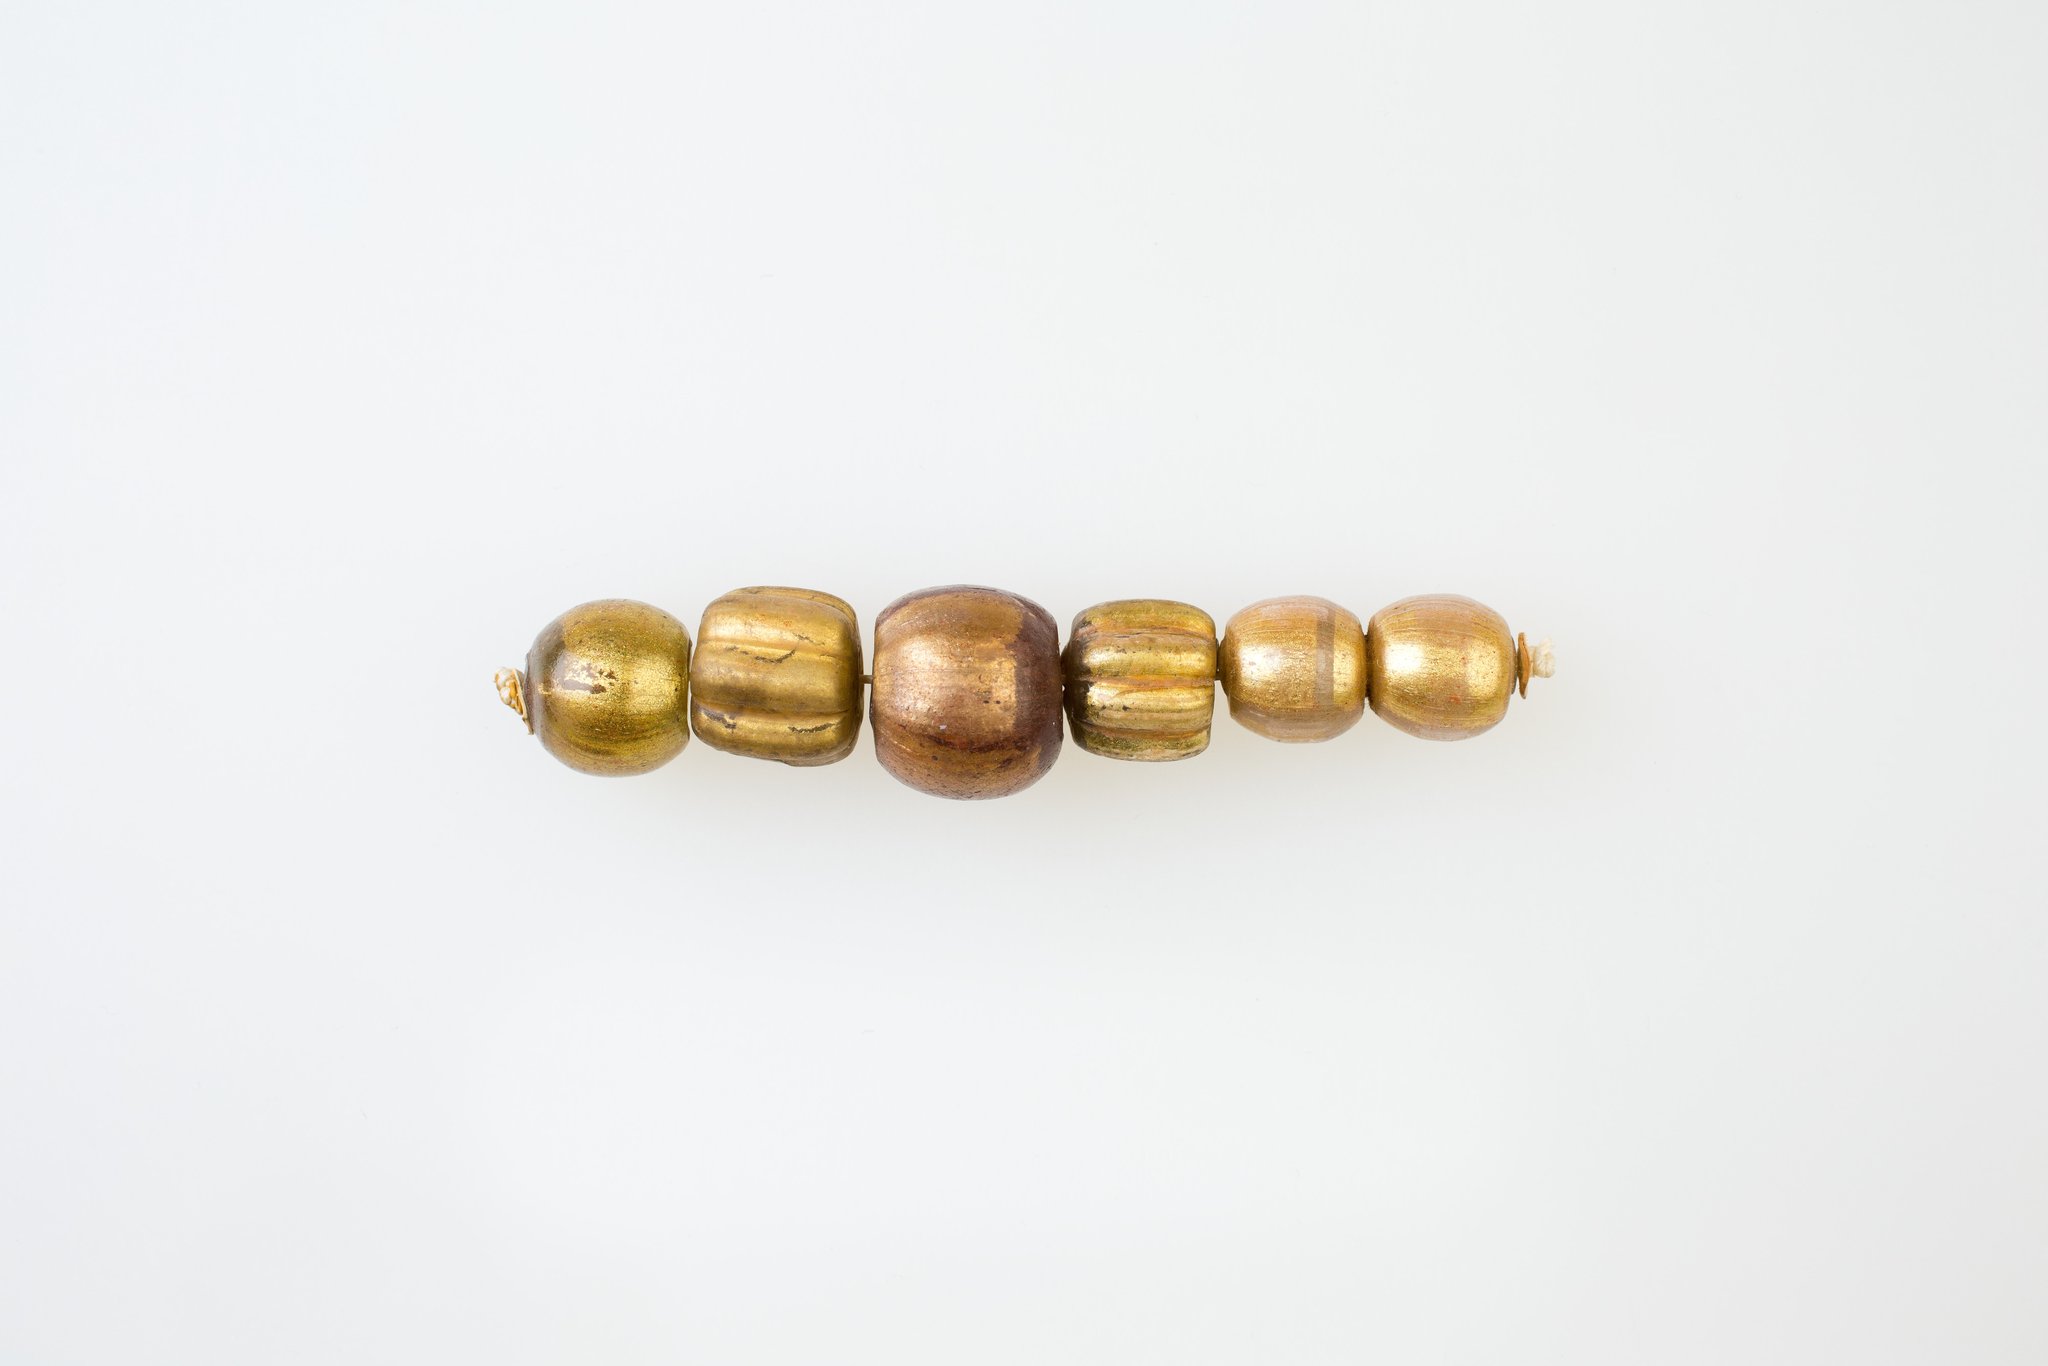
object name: bead, string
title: String of 6 Beads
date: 200 BCE-200 CE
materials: glass, gold foil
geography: egypt